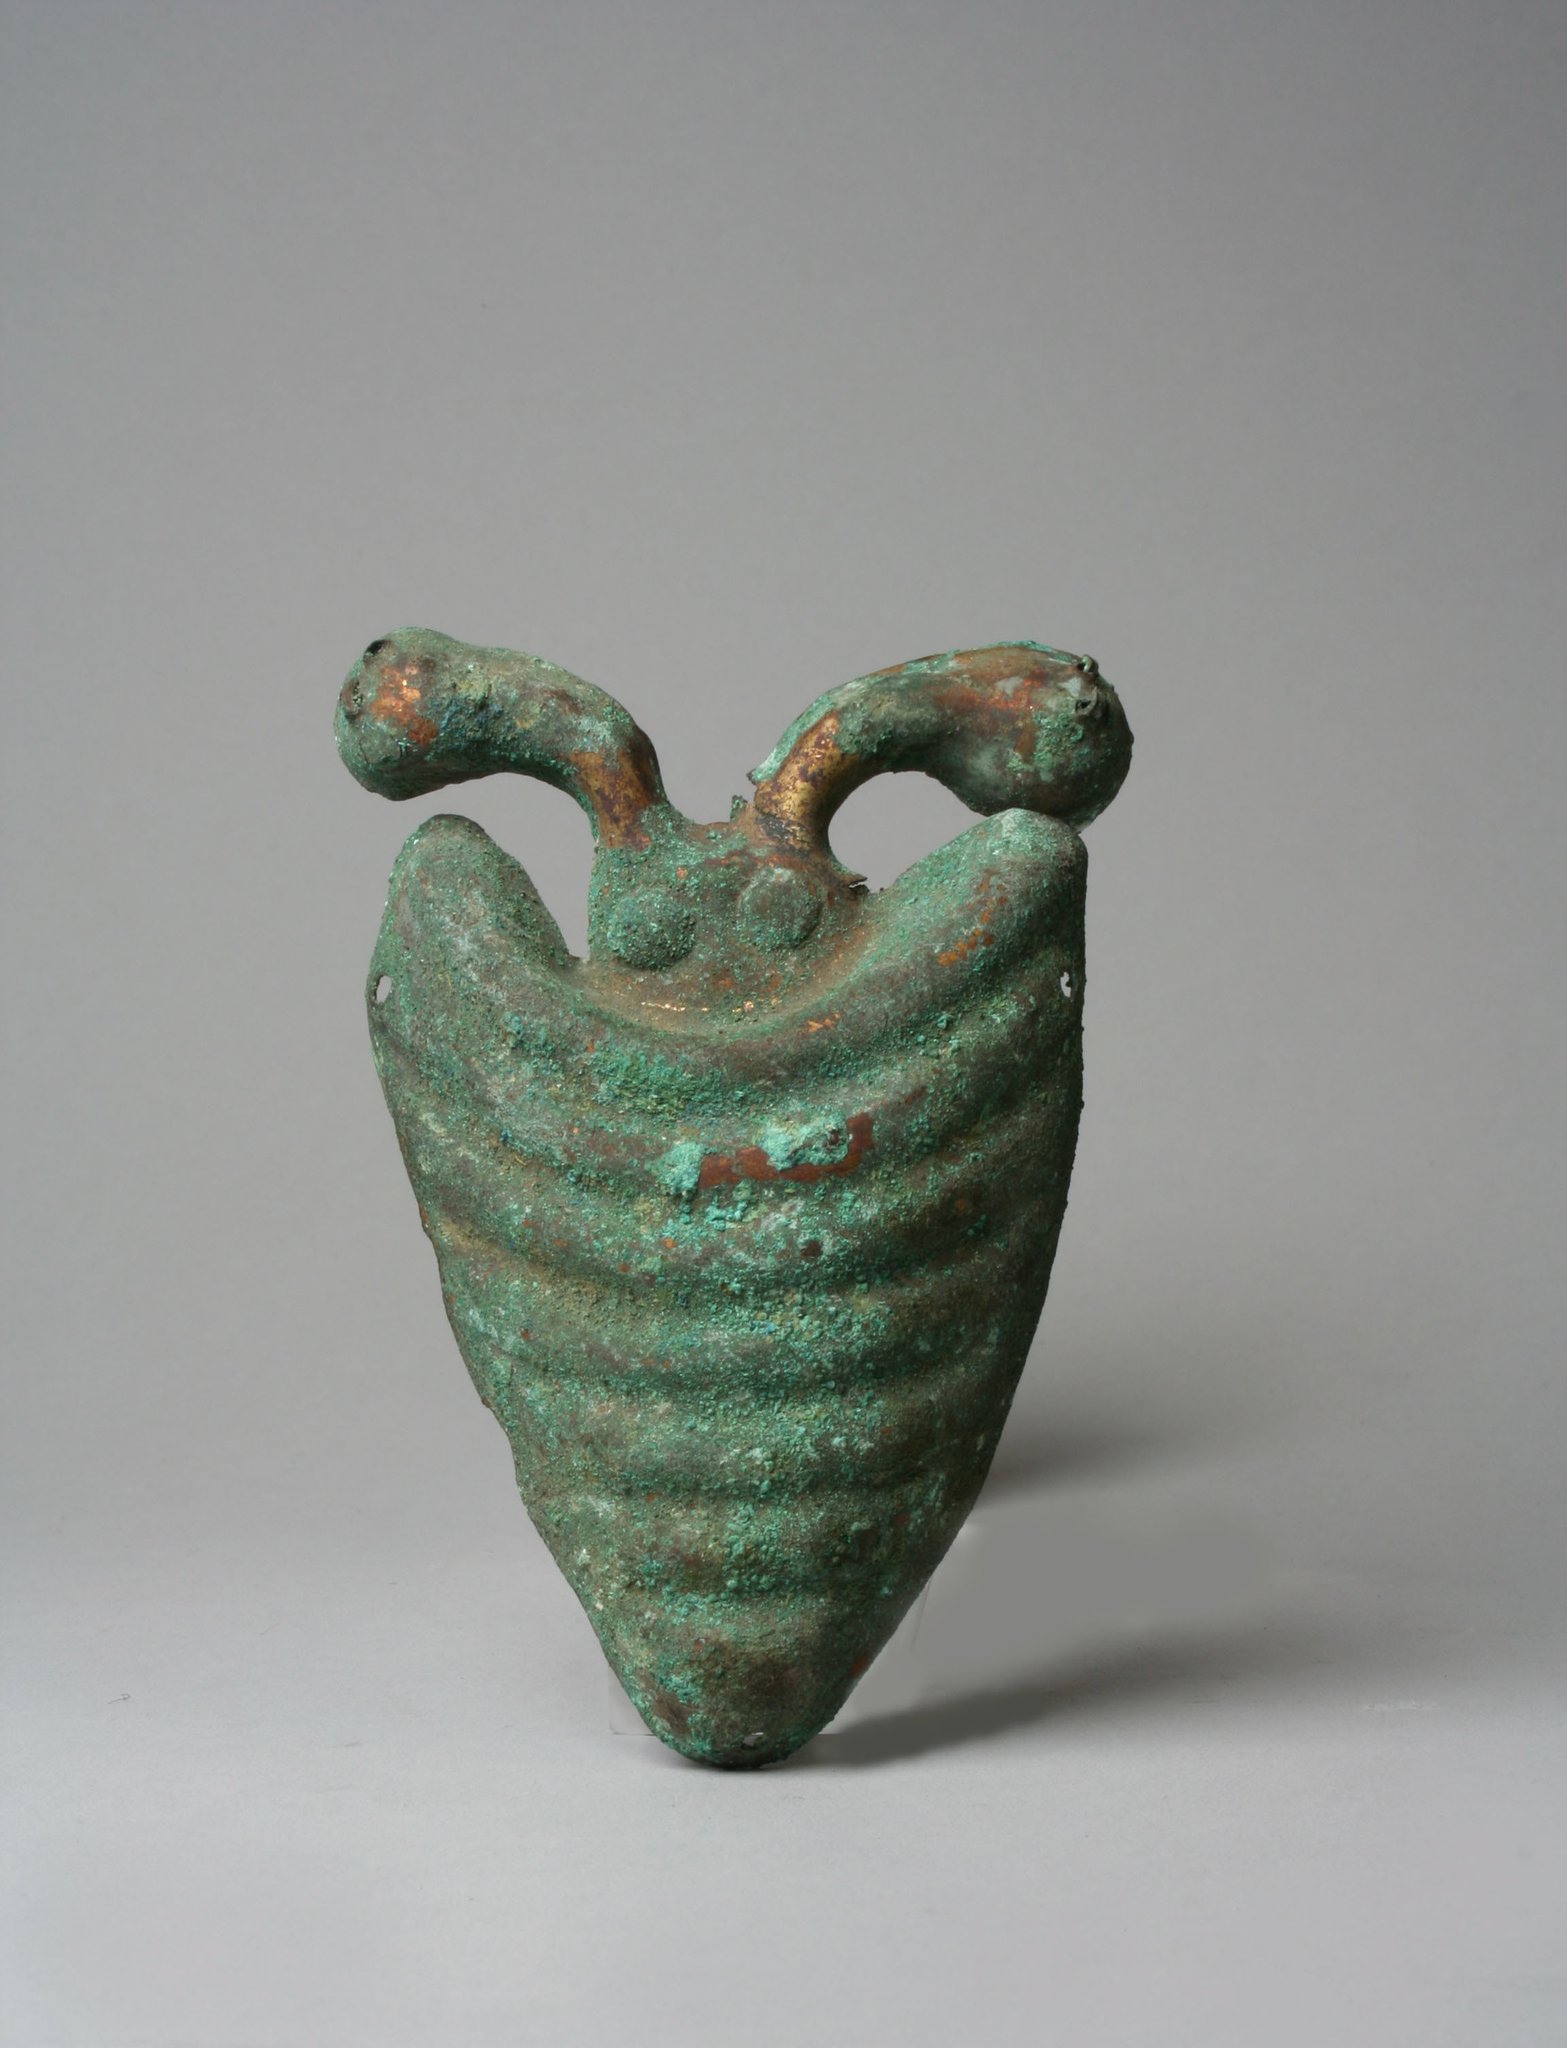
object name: ornament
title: Animal Ornament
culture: moche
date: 501-700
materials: gilt copper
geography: peru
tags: animals